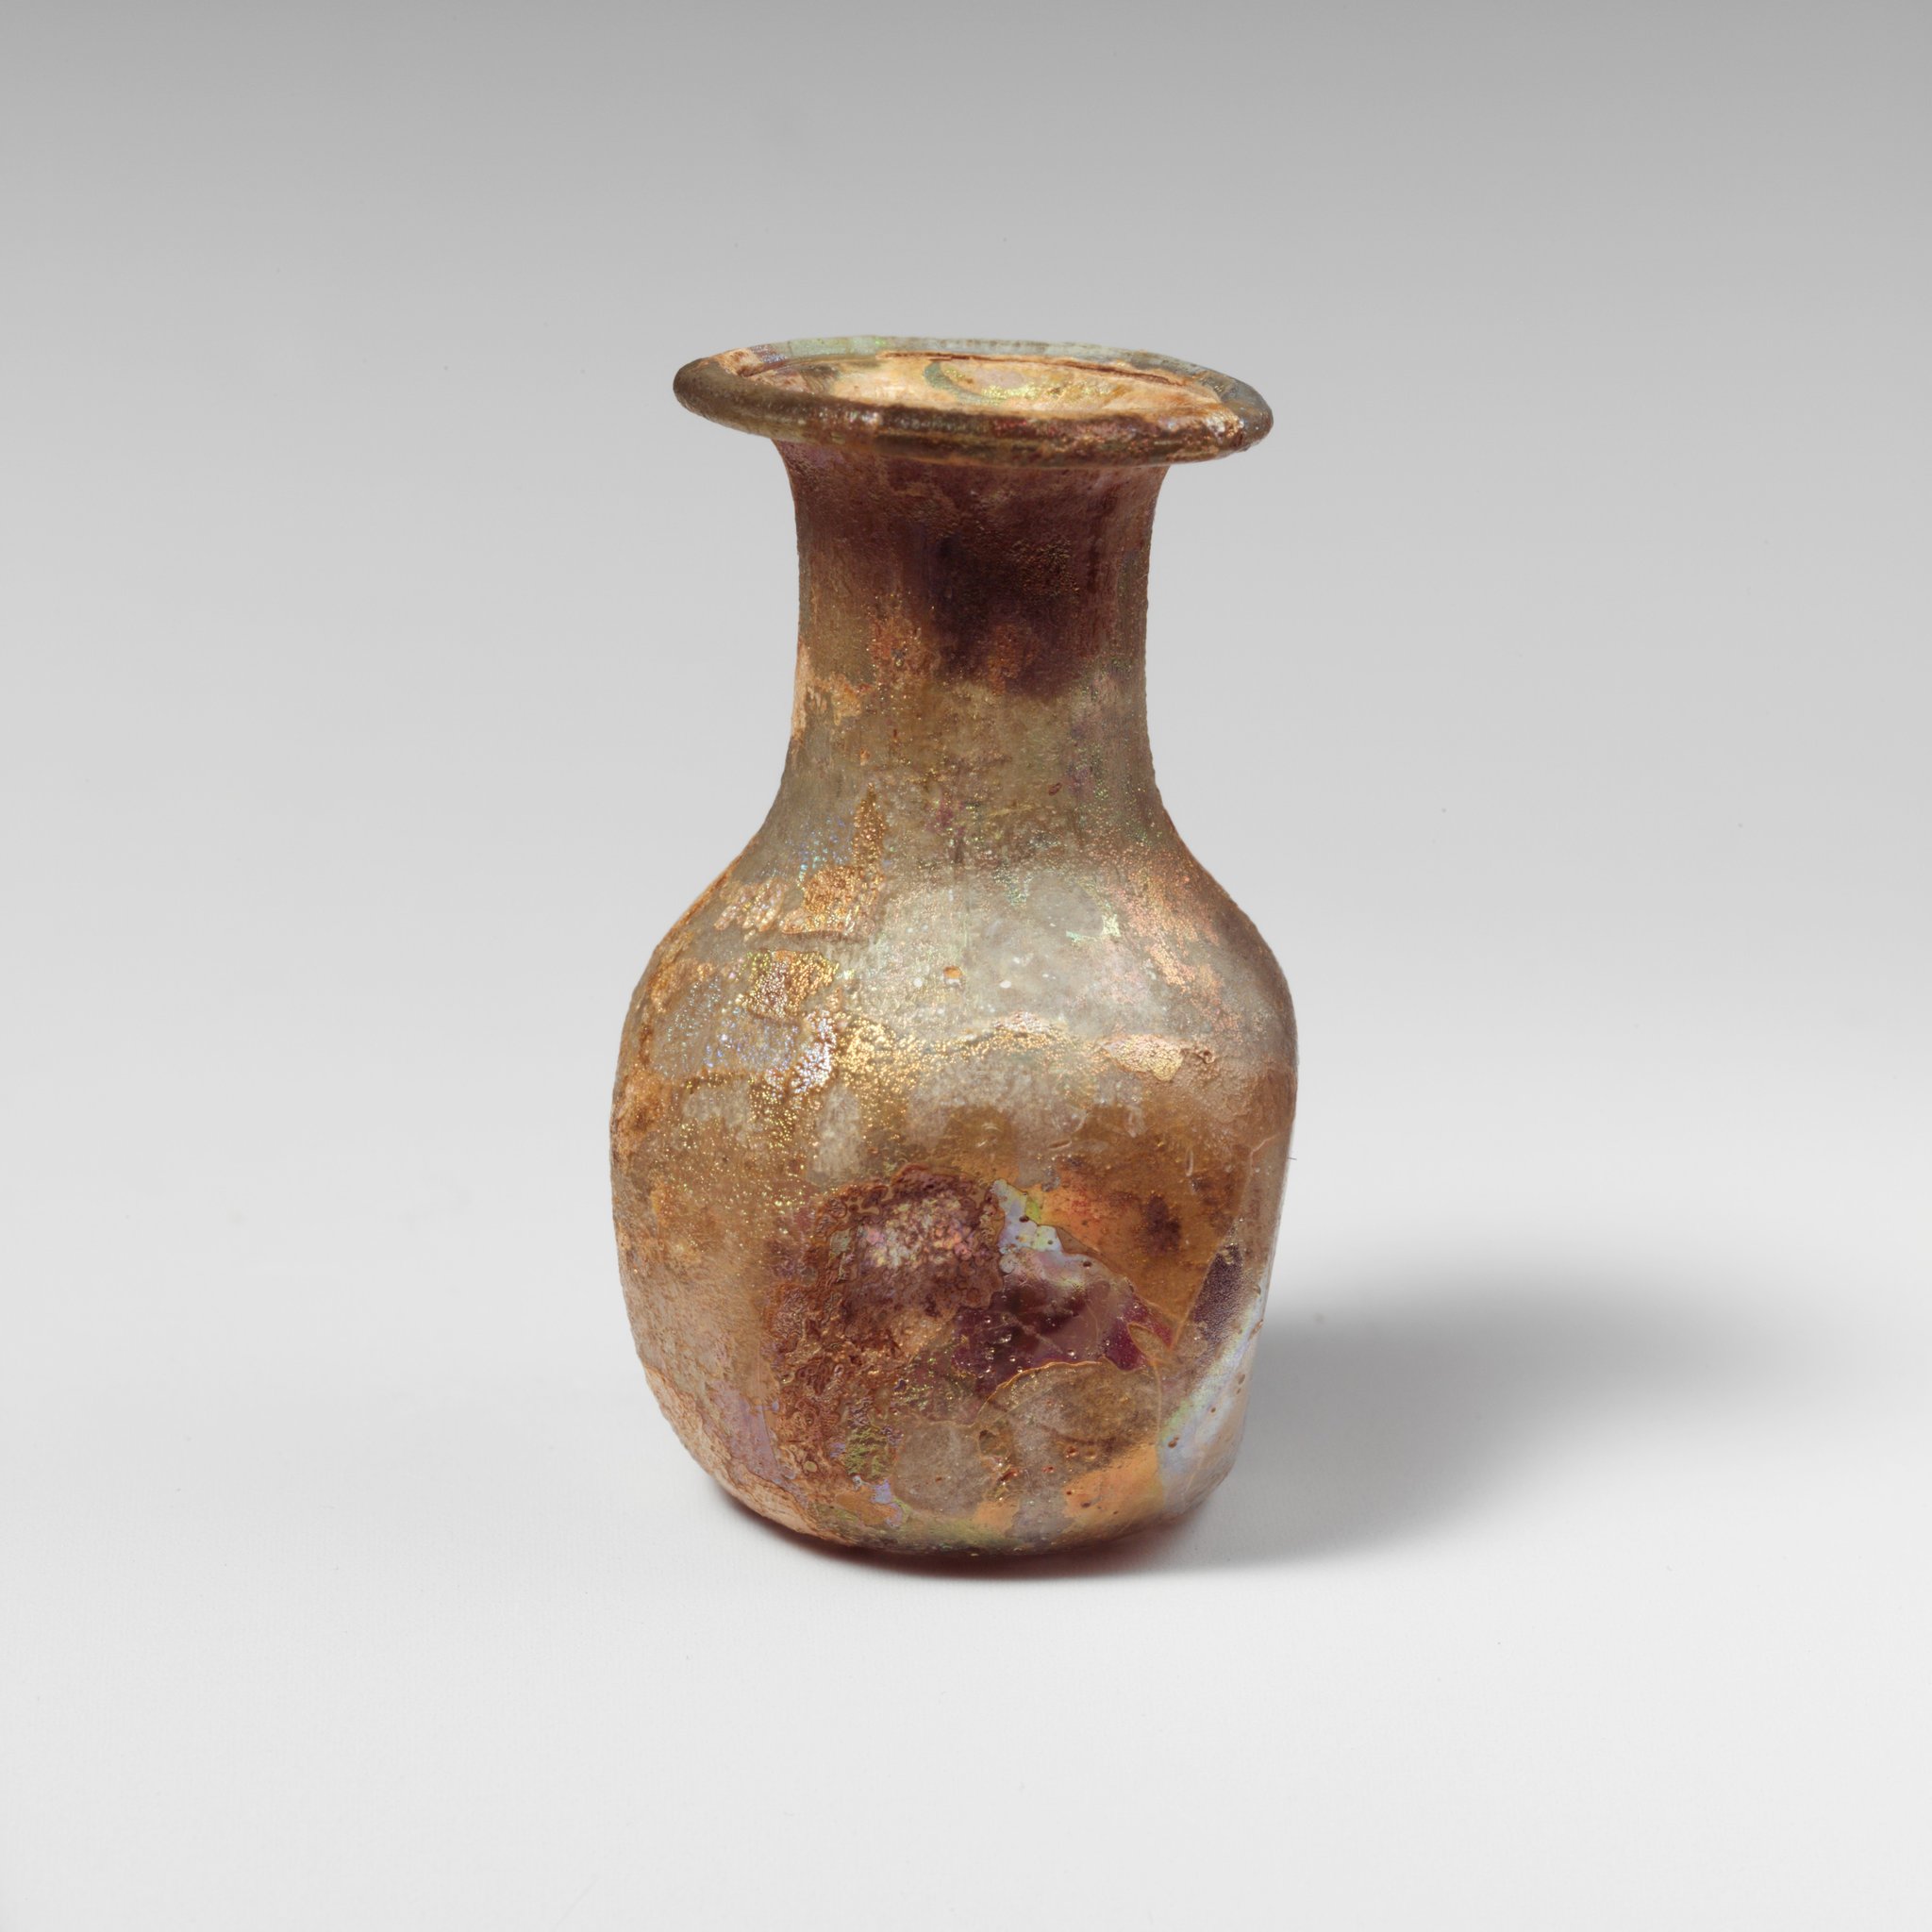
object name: bottle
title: Glass perfume bottle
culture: roman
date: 101-300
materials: glass